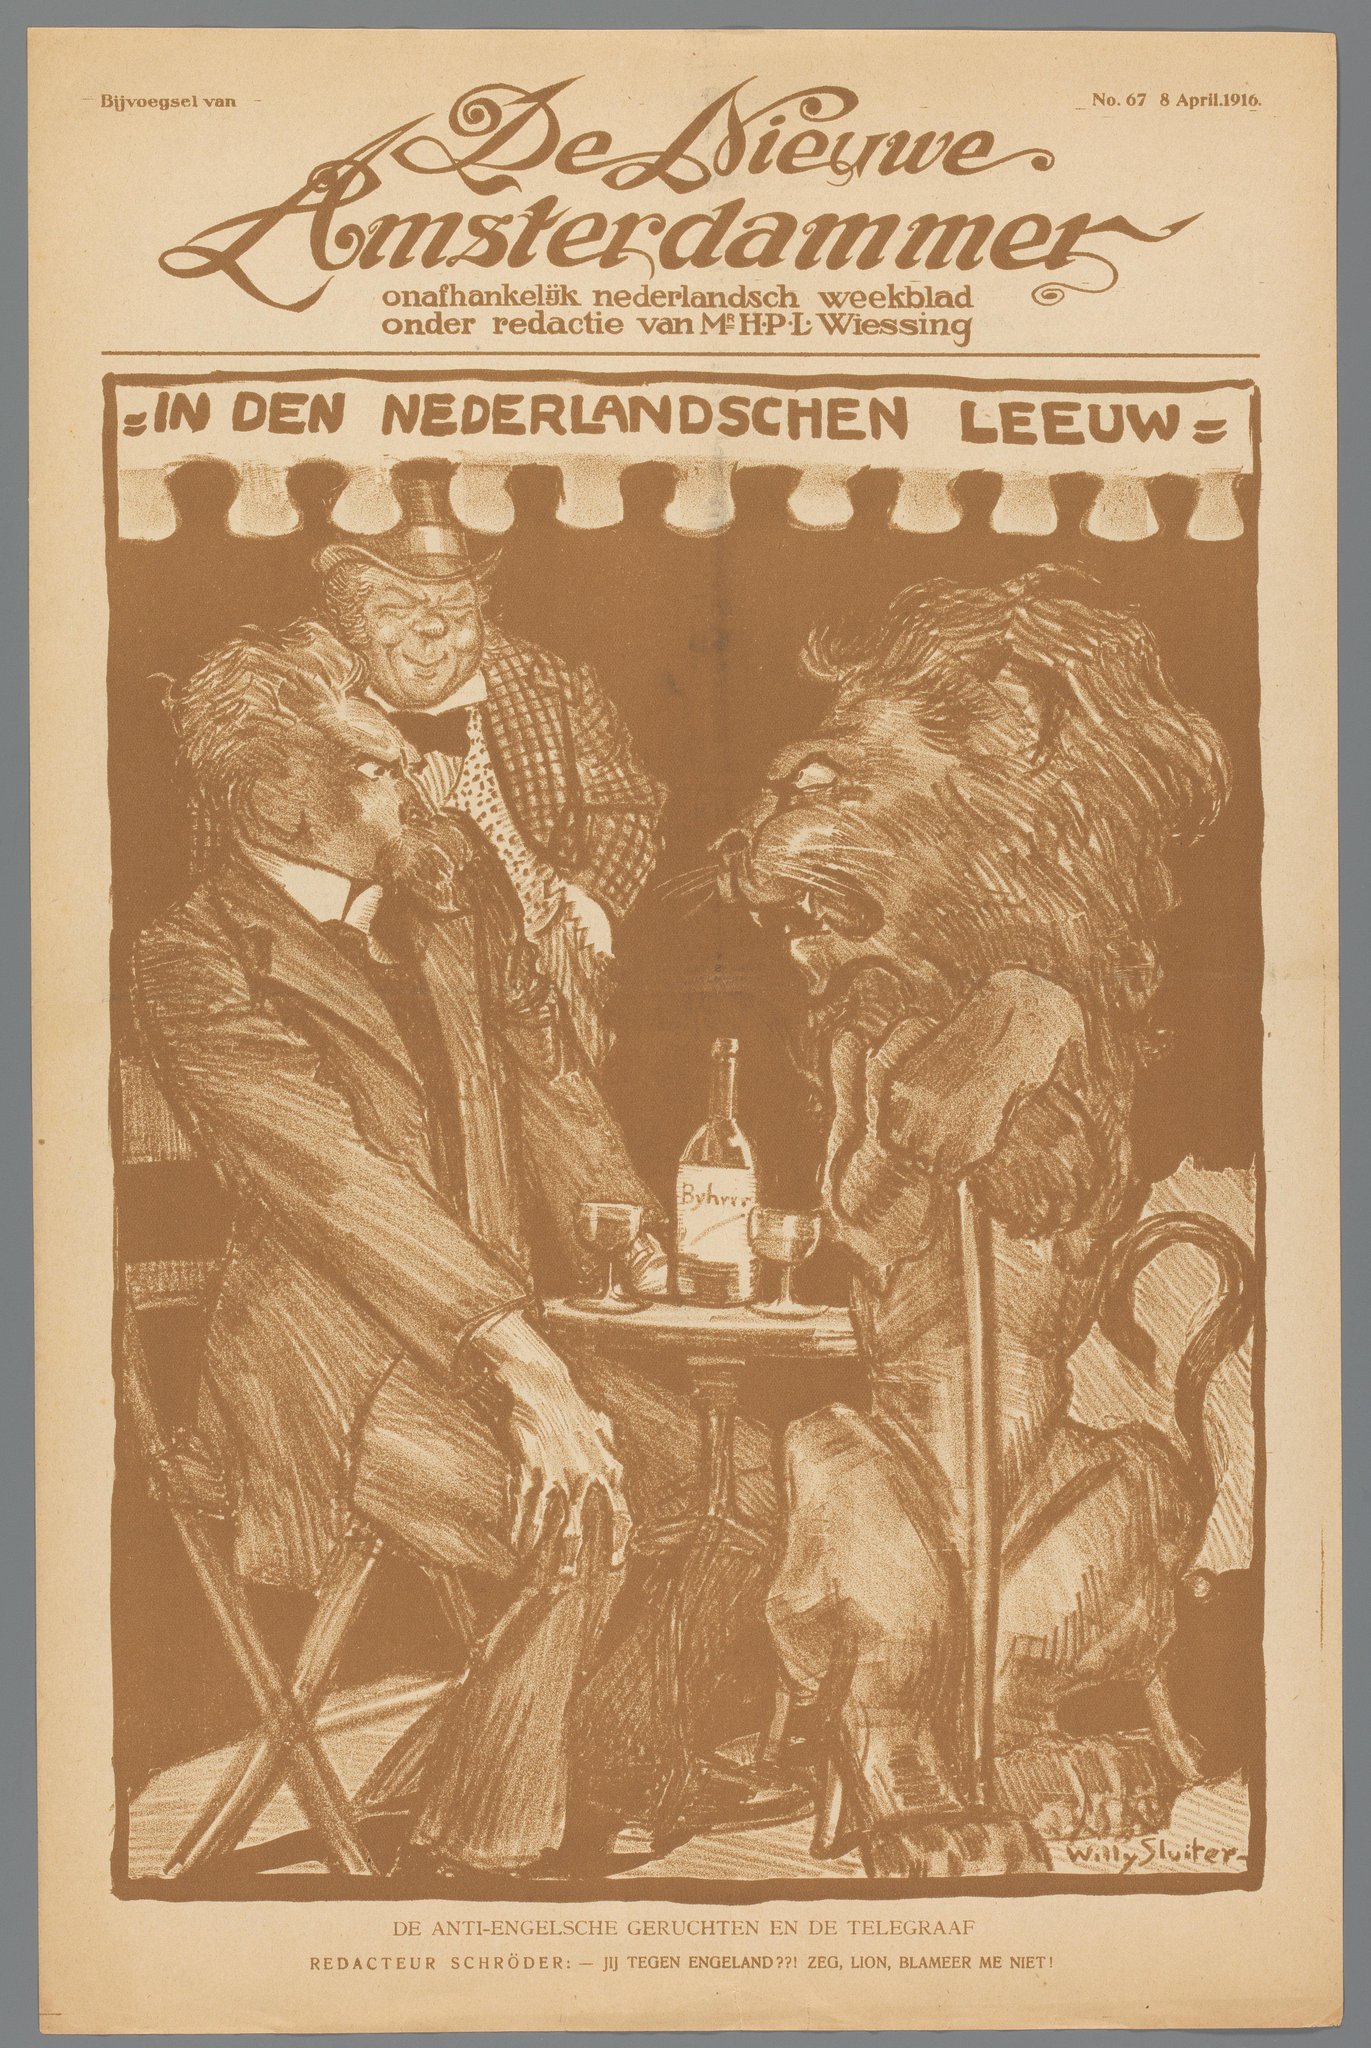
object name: print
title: De anti-Engelsche geruchten en de Telegraaf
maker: willy sluiter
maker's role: draughtsman, painter, print maker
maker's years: 1873-1949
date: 1916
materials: paper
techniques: lithograph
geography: netherlands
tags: pavement, terrace in front of inn or restaurant, personifications of countries, nations, states, districts, etc. (+ nation; national), beasts of prey, predatory animals: lion, political caricatures and satires, netherlands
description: Hoofdredacteur van de Telegraaf Schröder als de Nederlandse leeuw in gesprek met een onbekende man (Lion?), John Bull kijkt glimlachend toe. Spotprent over Nederlandse binnenlandse politiek, 8 april 1916.